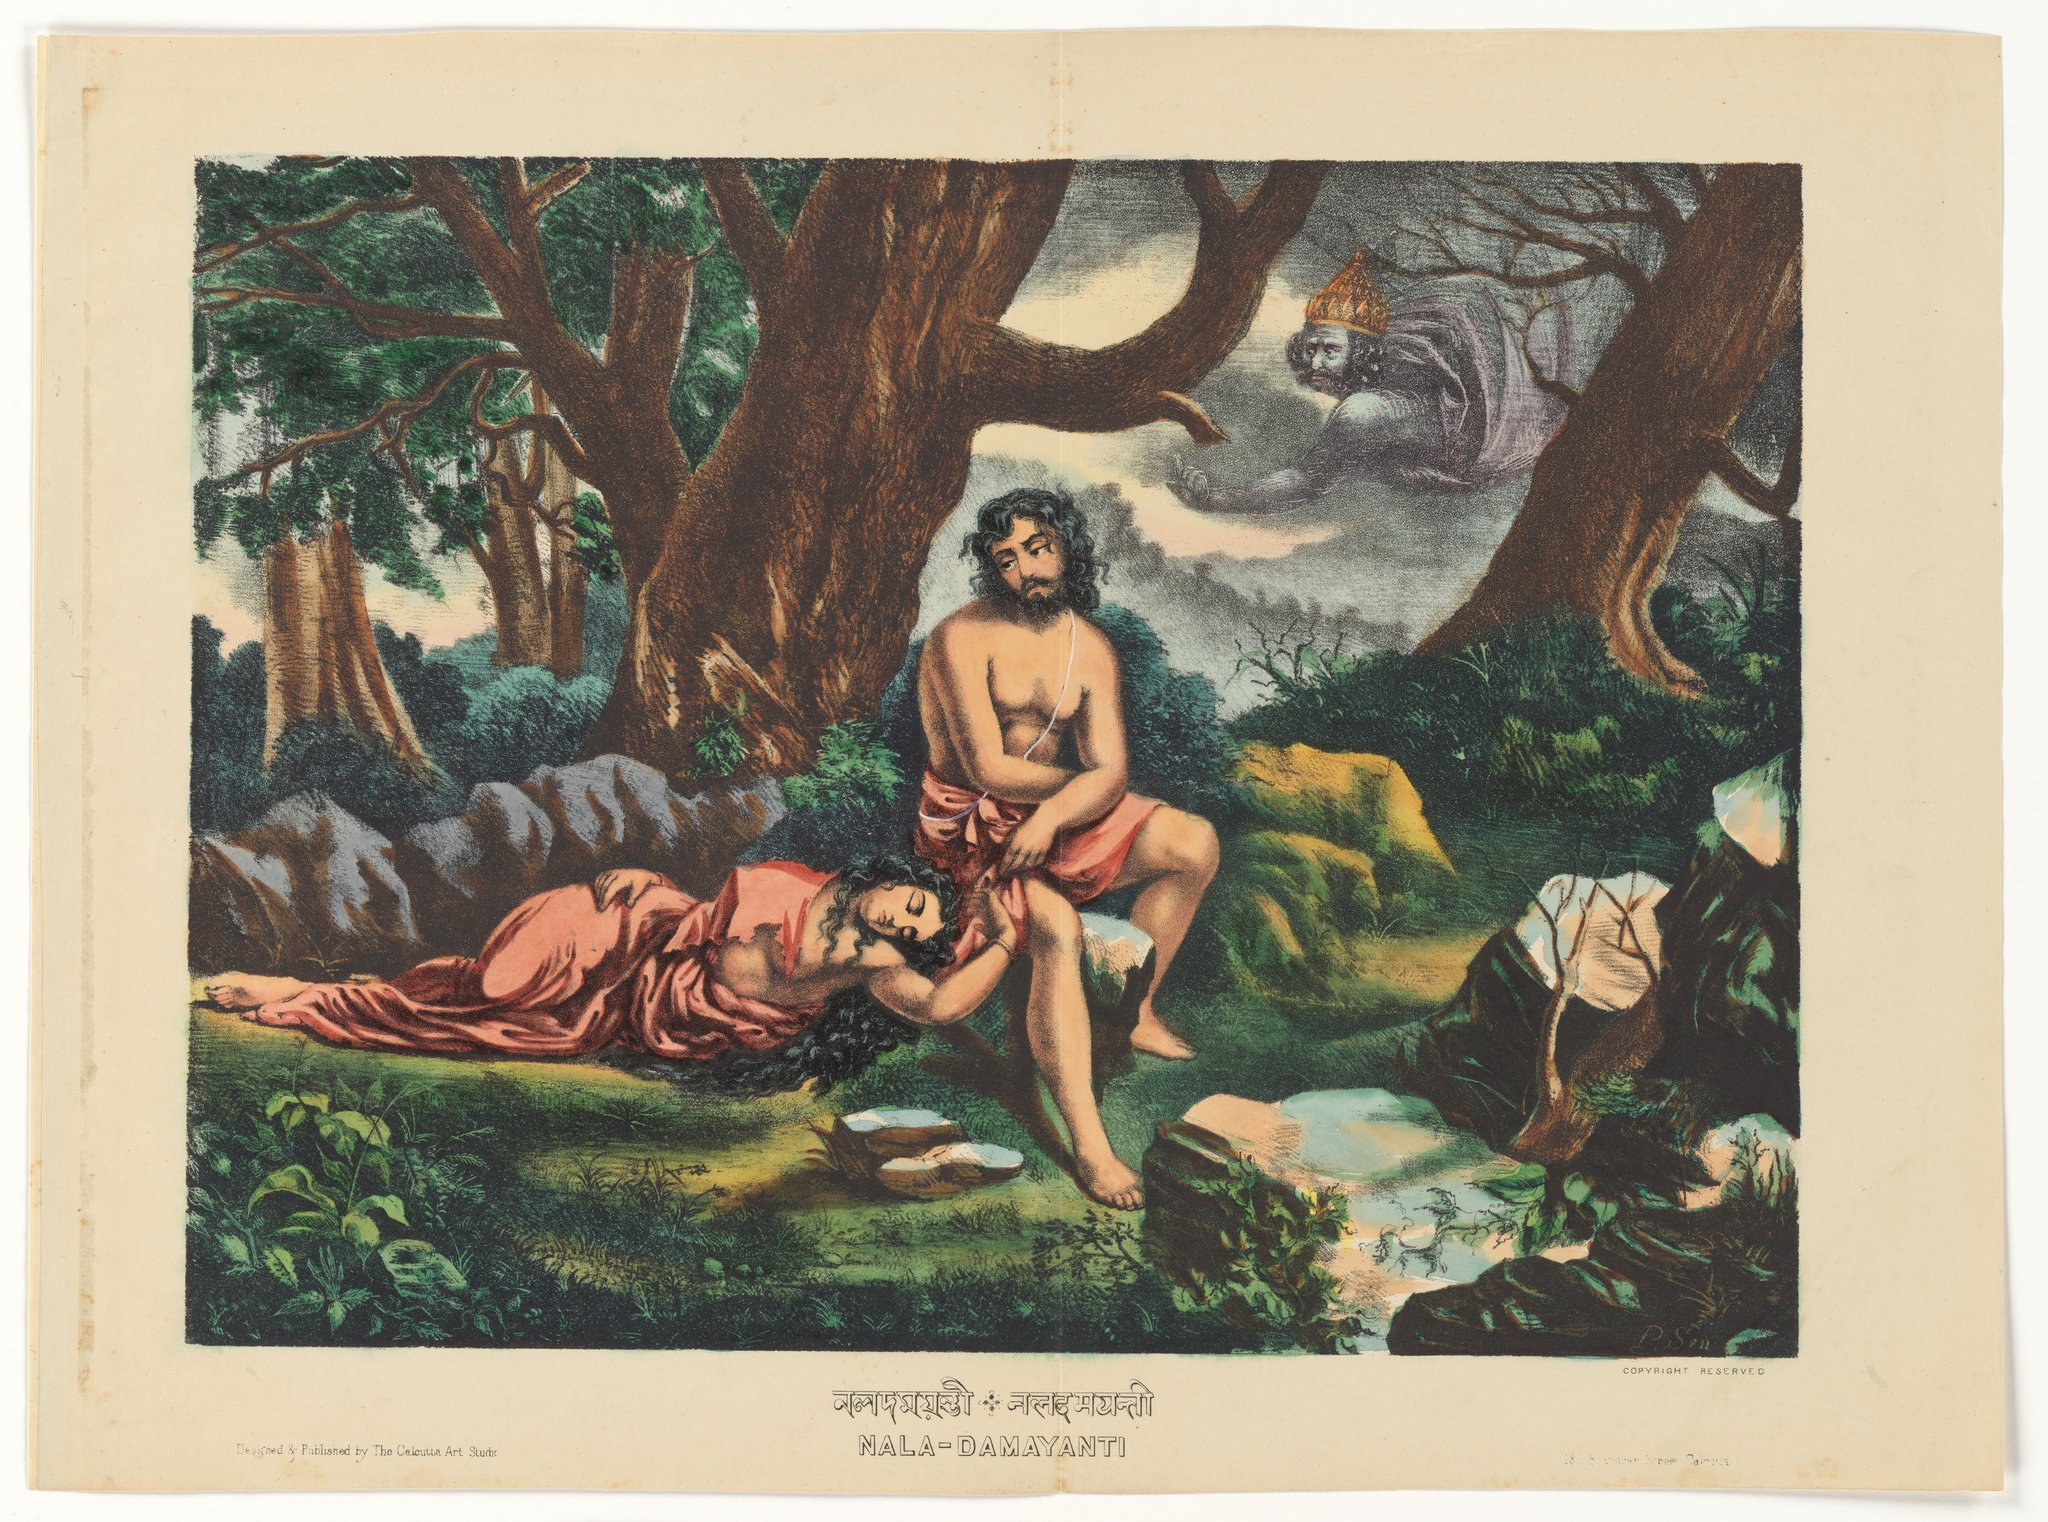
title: Nala Damayanti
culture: west bengali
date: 1878-1882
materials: glaze, watercolor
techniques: hand coloring, lithograph, printing